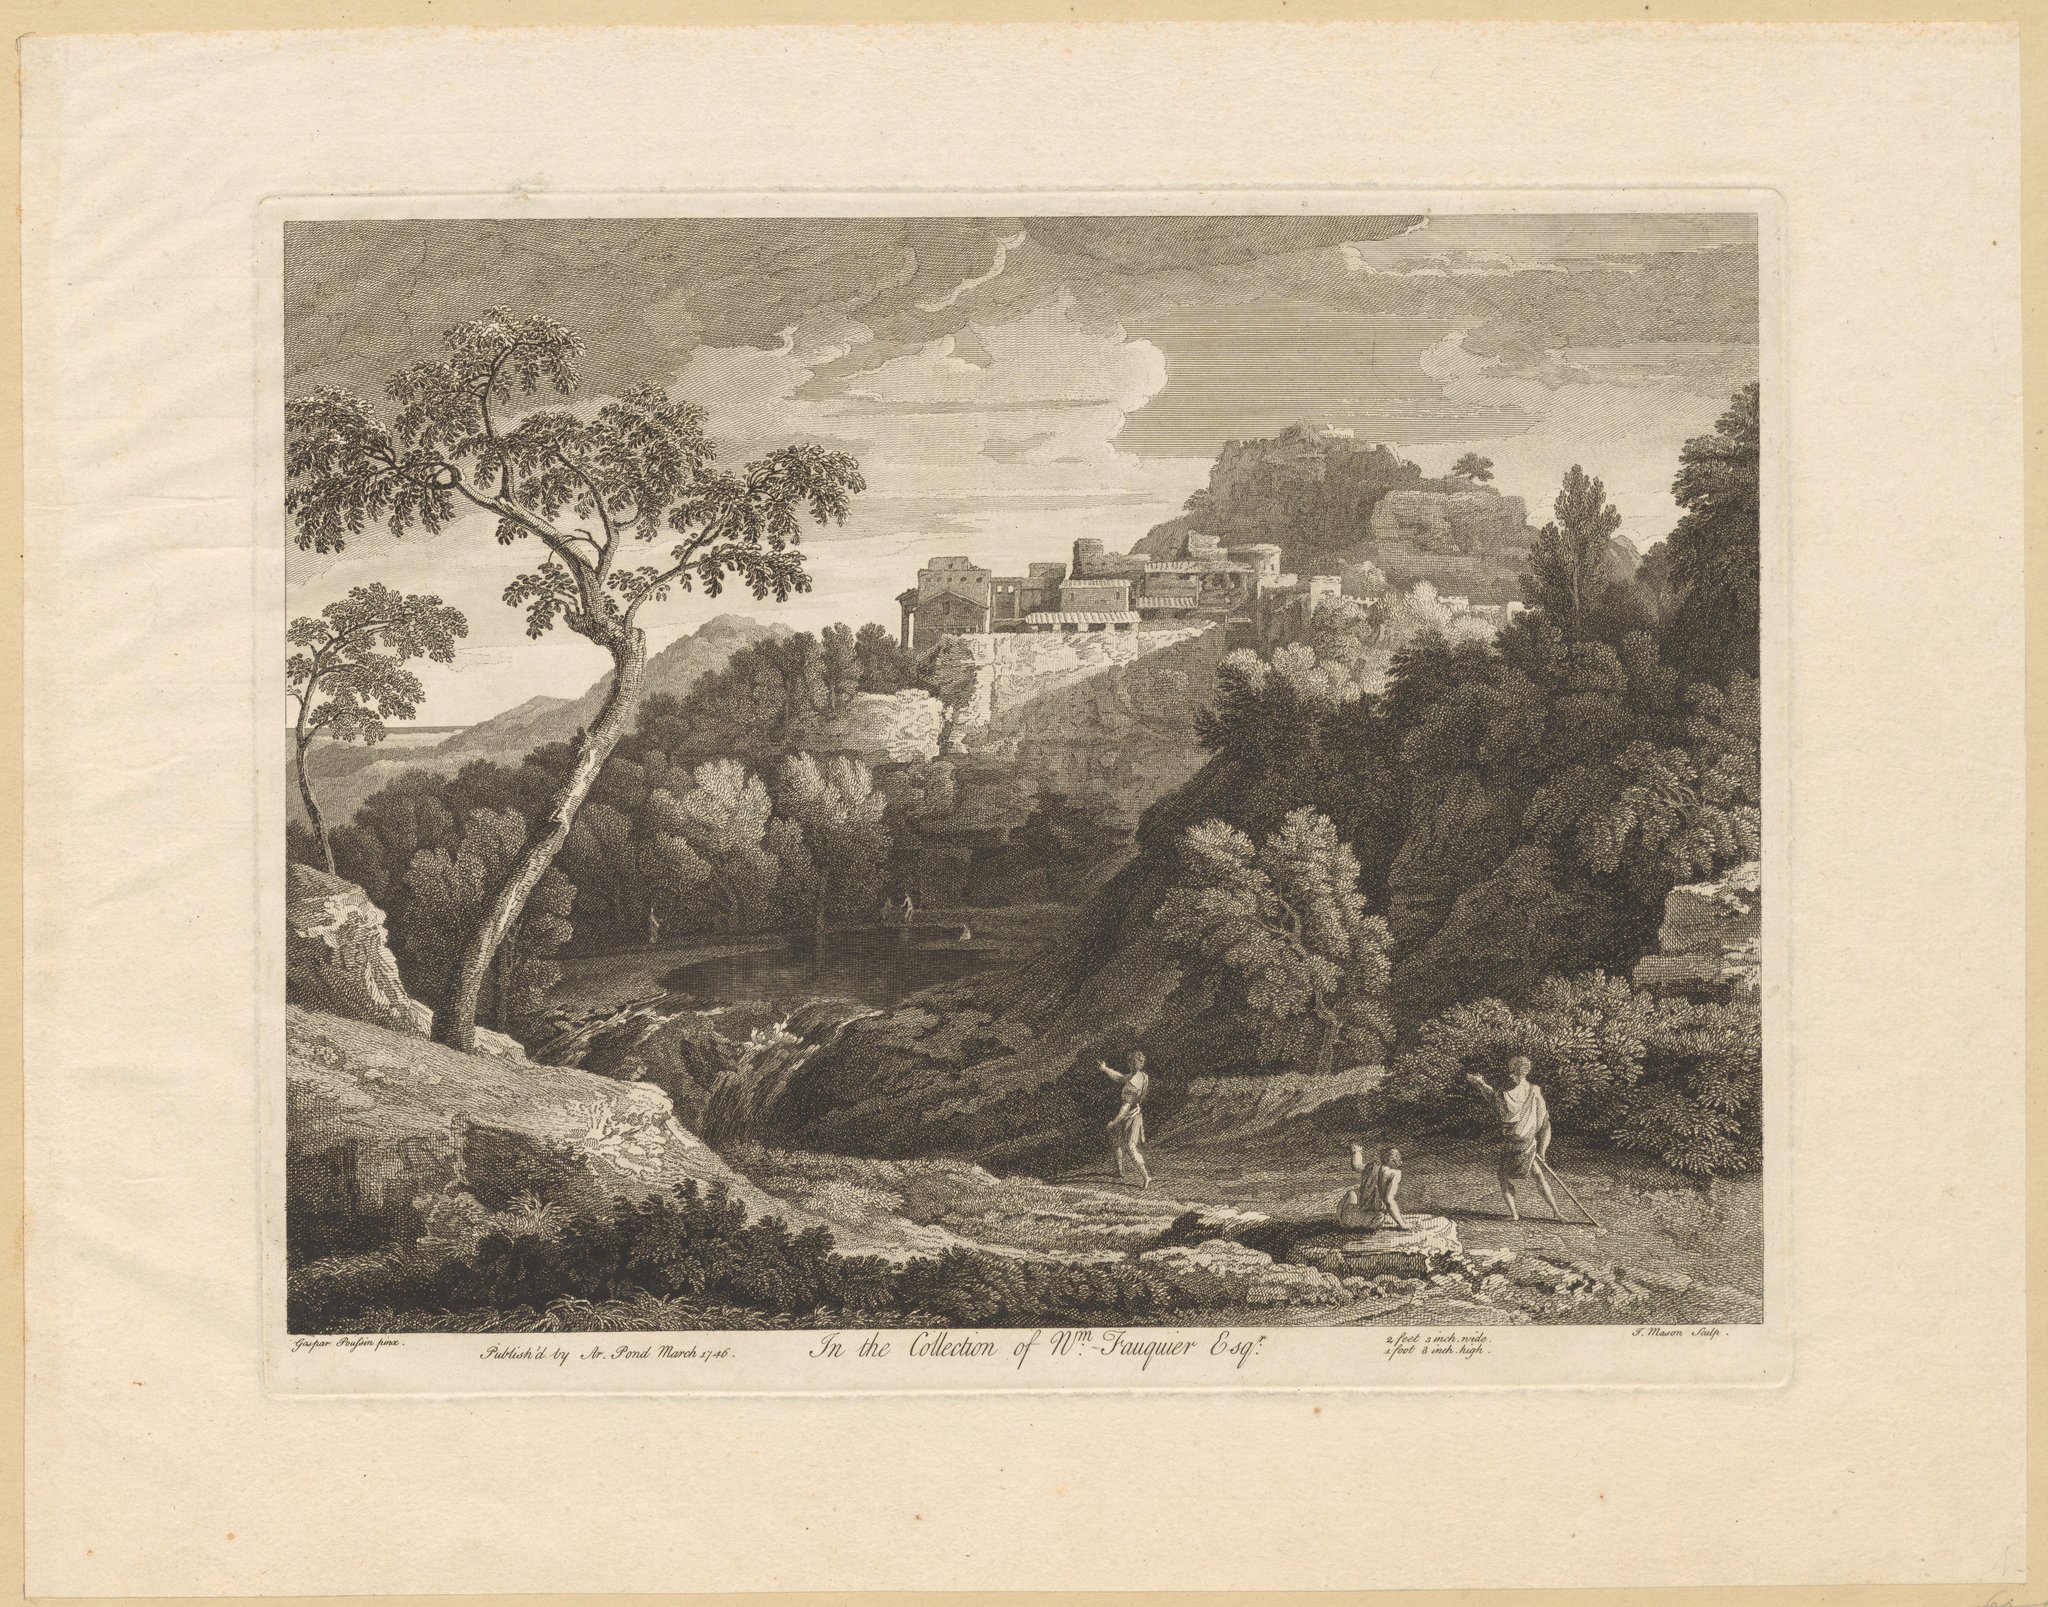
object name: print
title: Drie figuren wijzen naar een meer in een bosachtig landschap met dorp op een heuvel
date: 1703-1746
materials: paper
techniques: etching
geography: london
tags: trees, (high) hill, village, lake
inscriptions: date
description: De serie werd tussen 1741 en 1746 door Knapton en Pond uitgegeven.